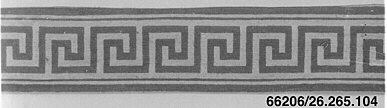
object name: border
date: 1801-1833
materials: cotton